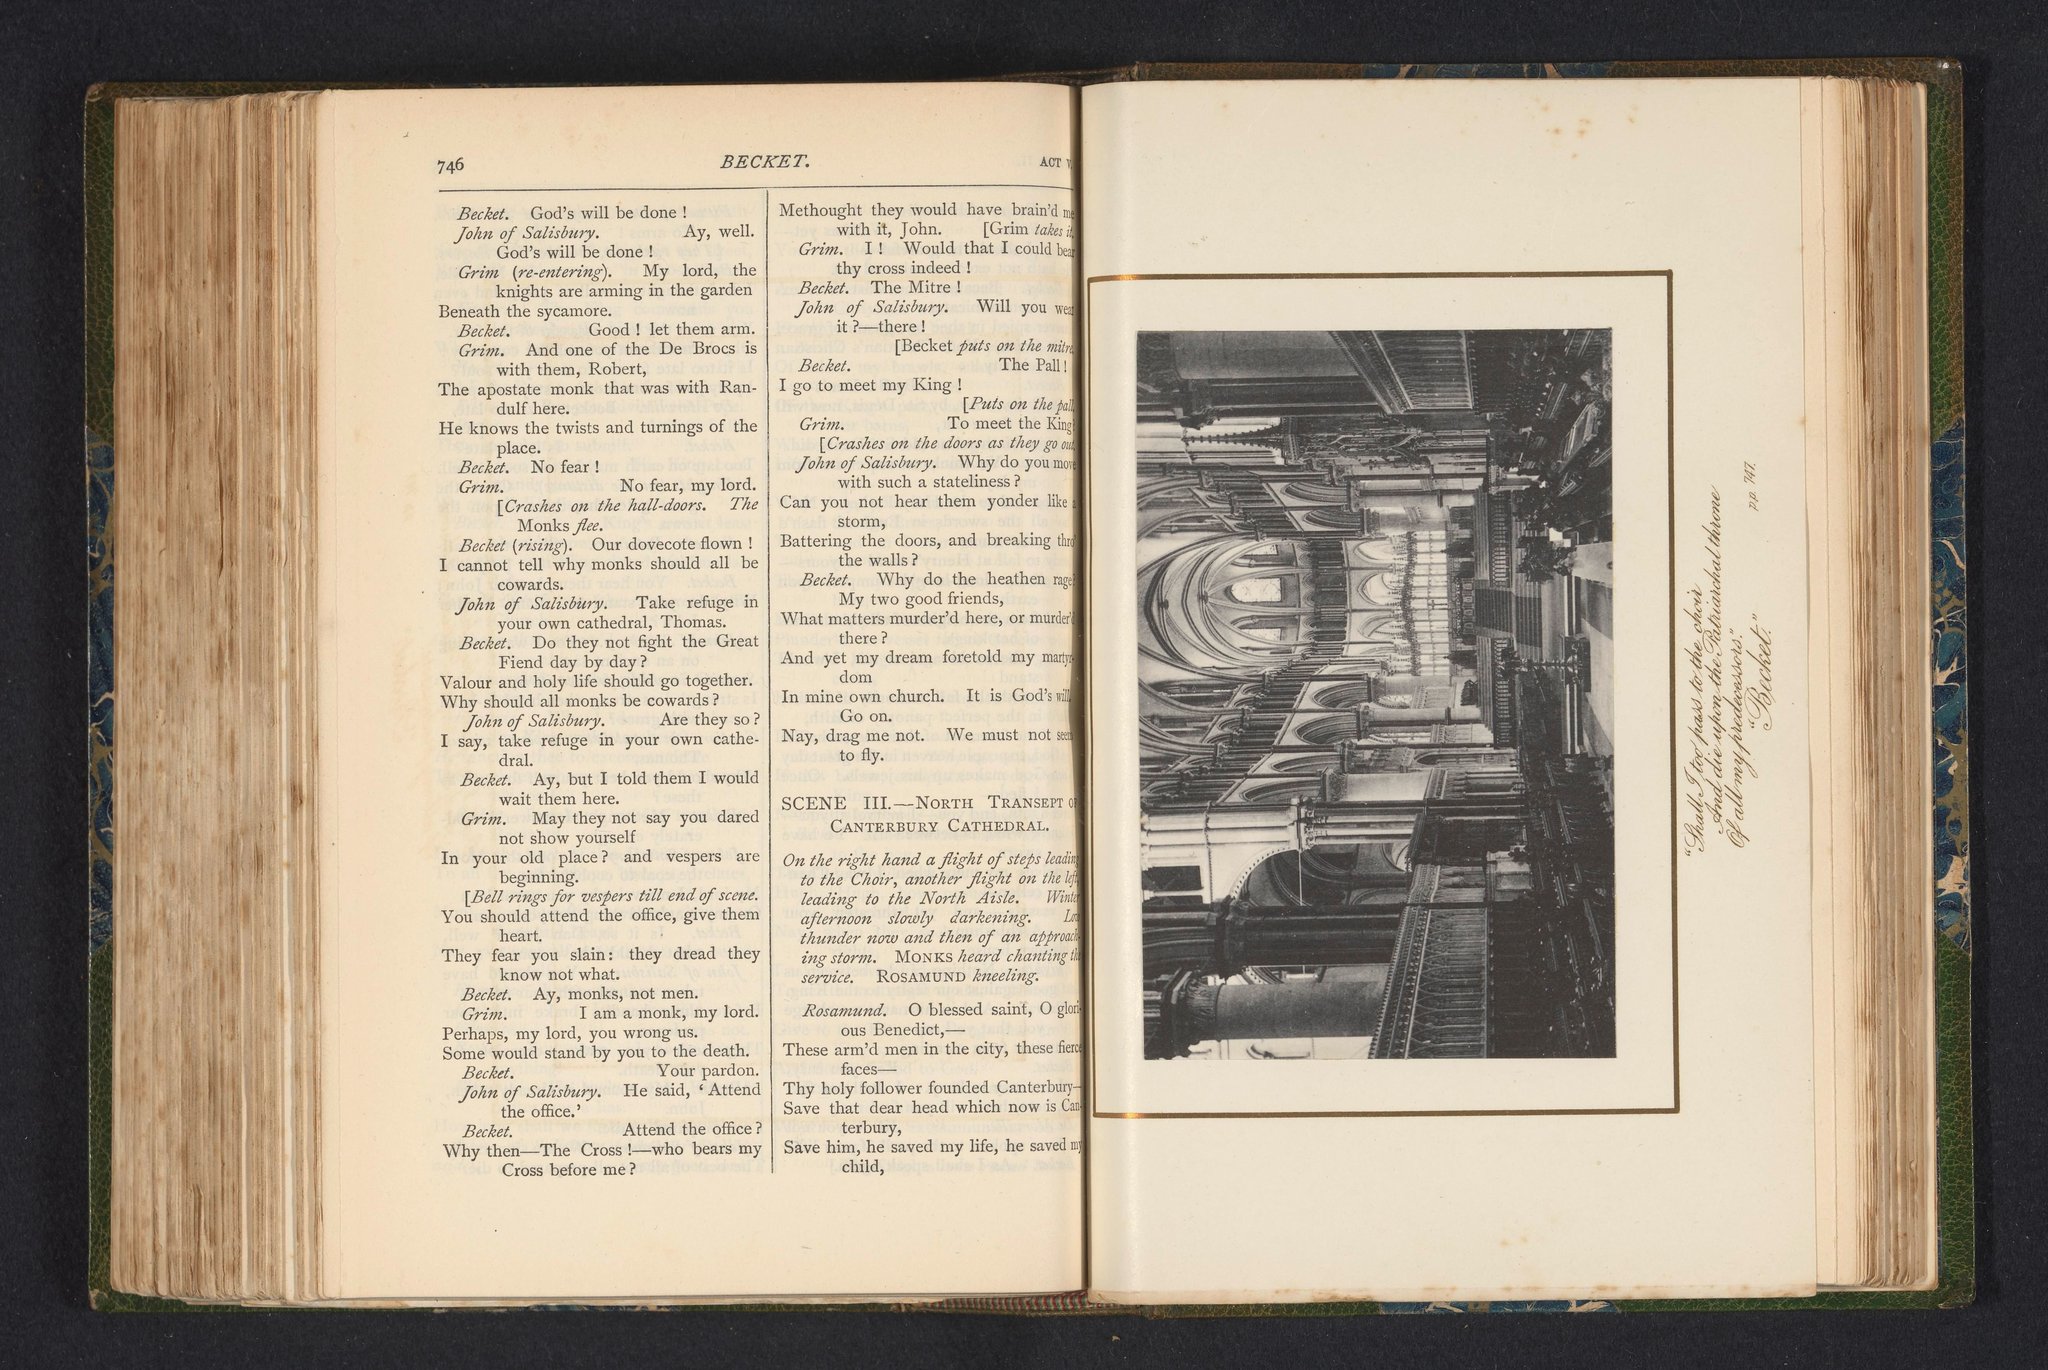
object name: page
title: Interieur van een kerk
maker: Anonymous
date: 1885-1895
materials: photographic support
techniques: platinum process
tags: interior of church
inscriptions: inscription: ‘"Shall I too (...) Becket"’